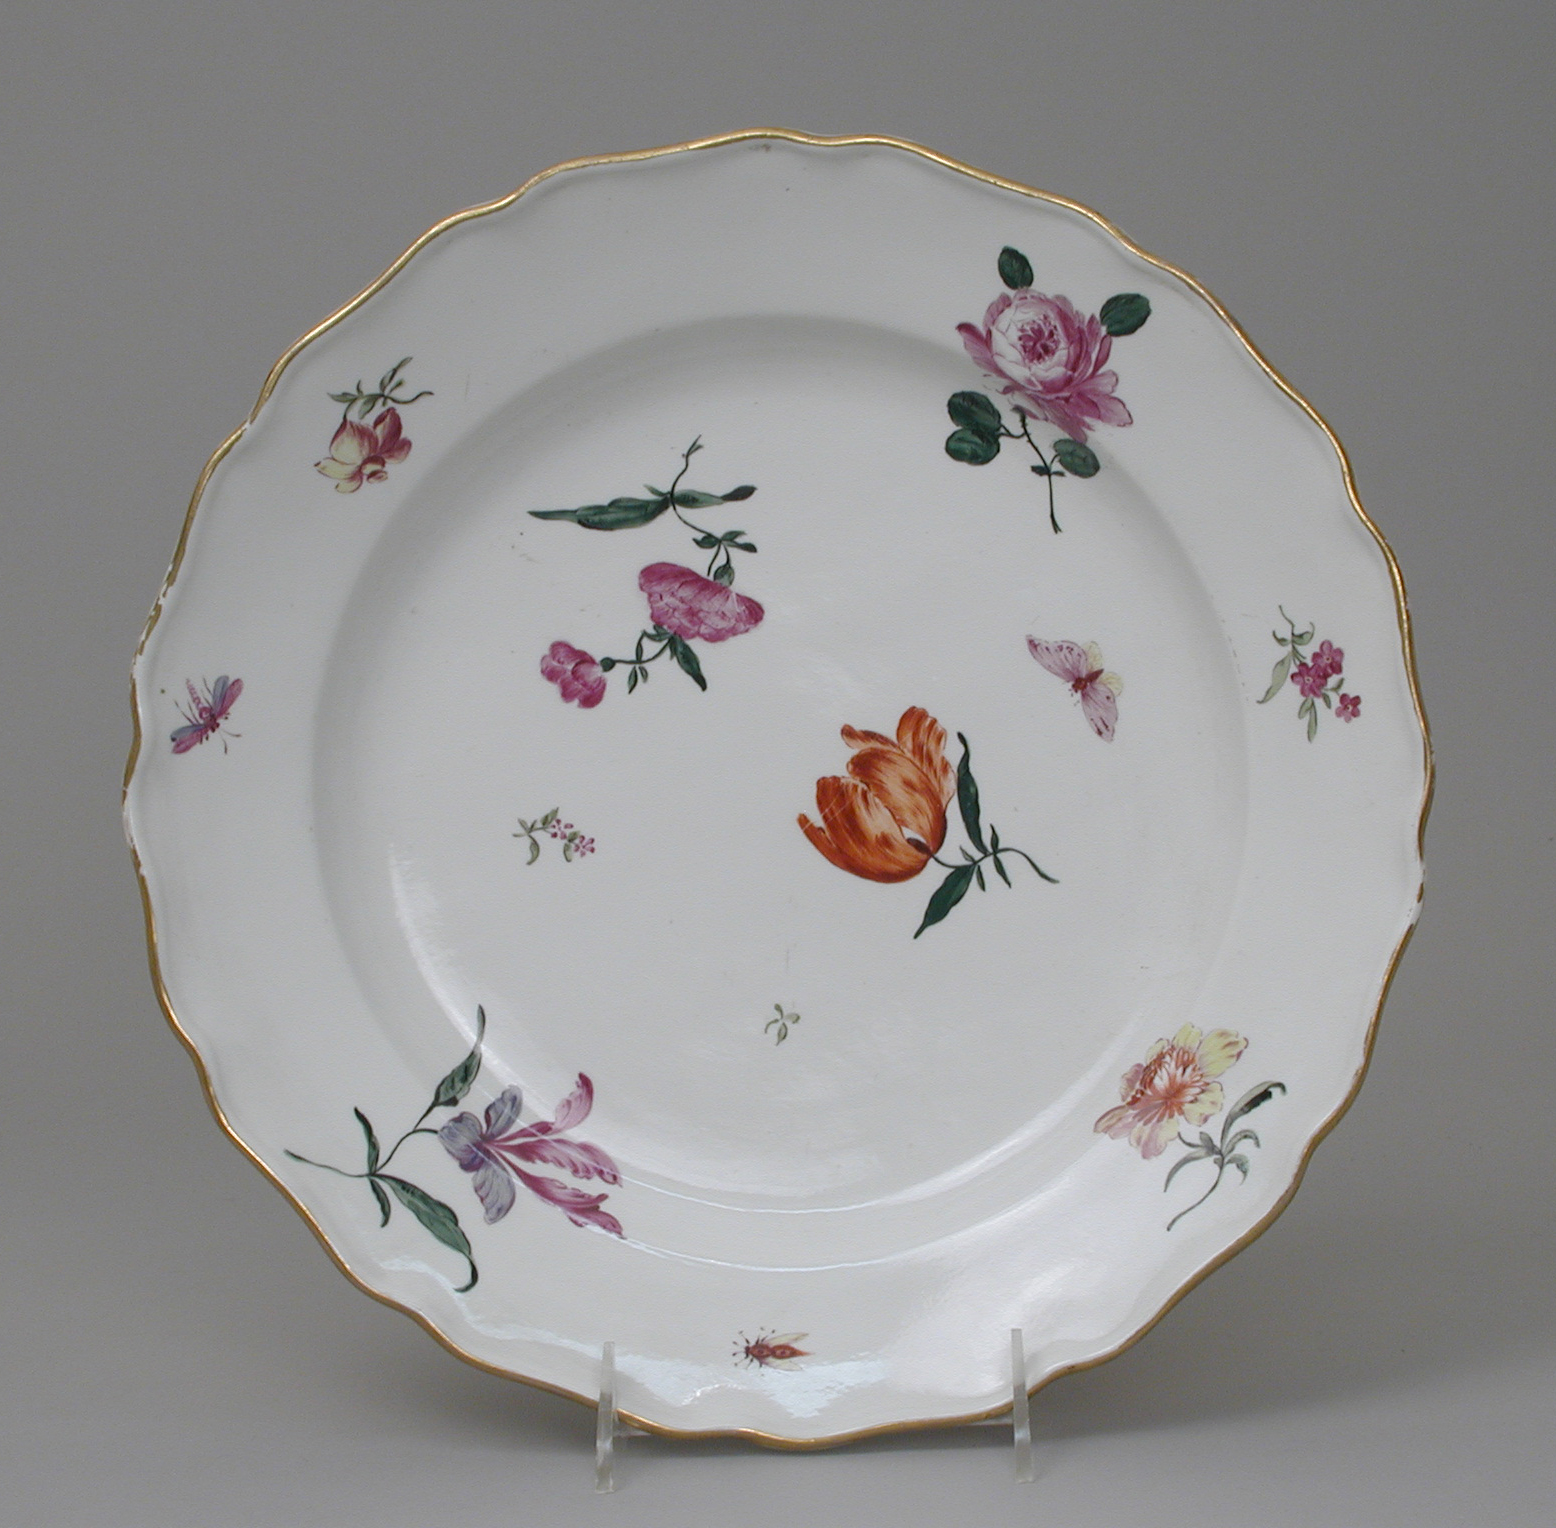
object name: plate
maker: nymphenburg porcelain manufactory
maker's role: manufactory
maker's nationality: german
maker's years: 1747-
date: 1770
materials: hard paste porcelain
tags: butterflies,flowers